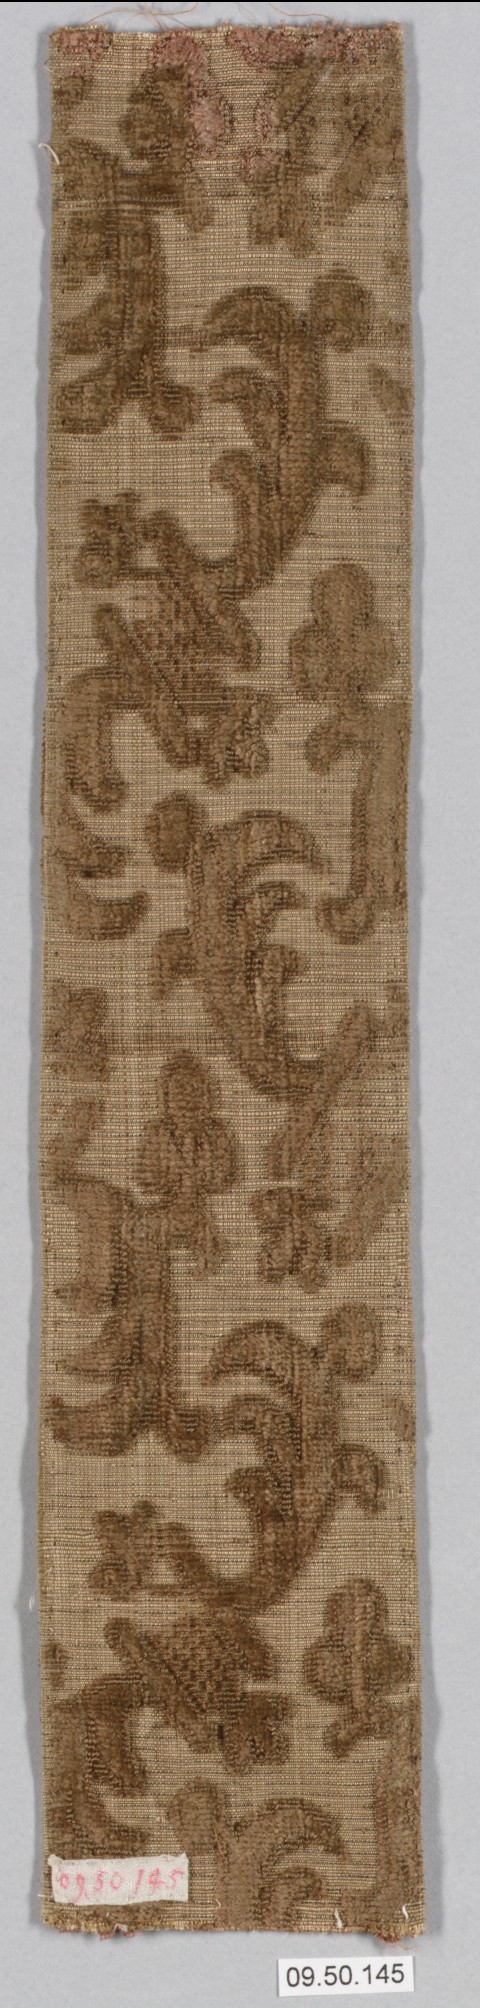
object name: piece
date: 1501-1700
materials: metal thread, silk